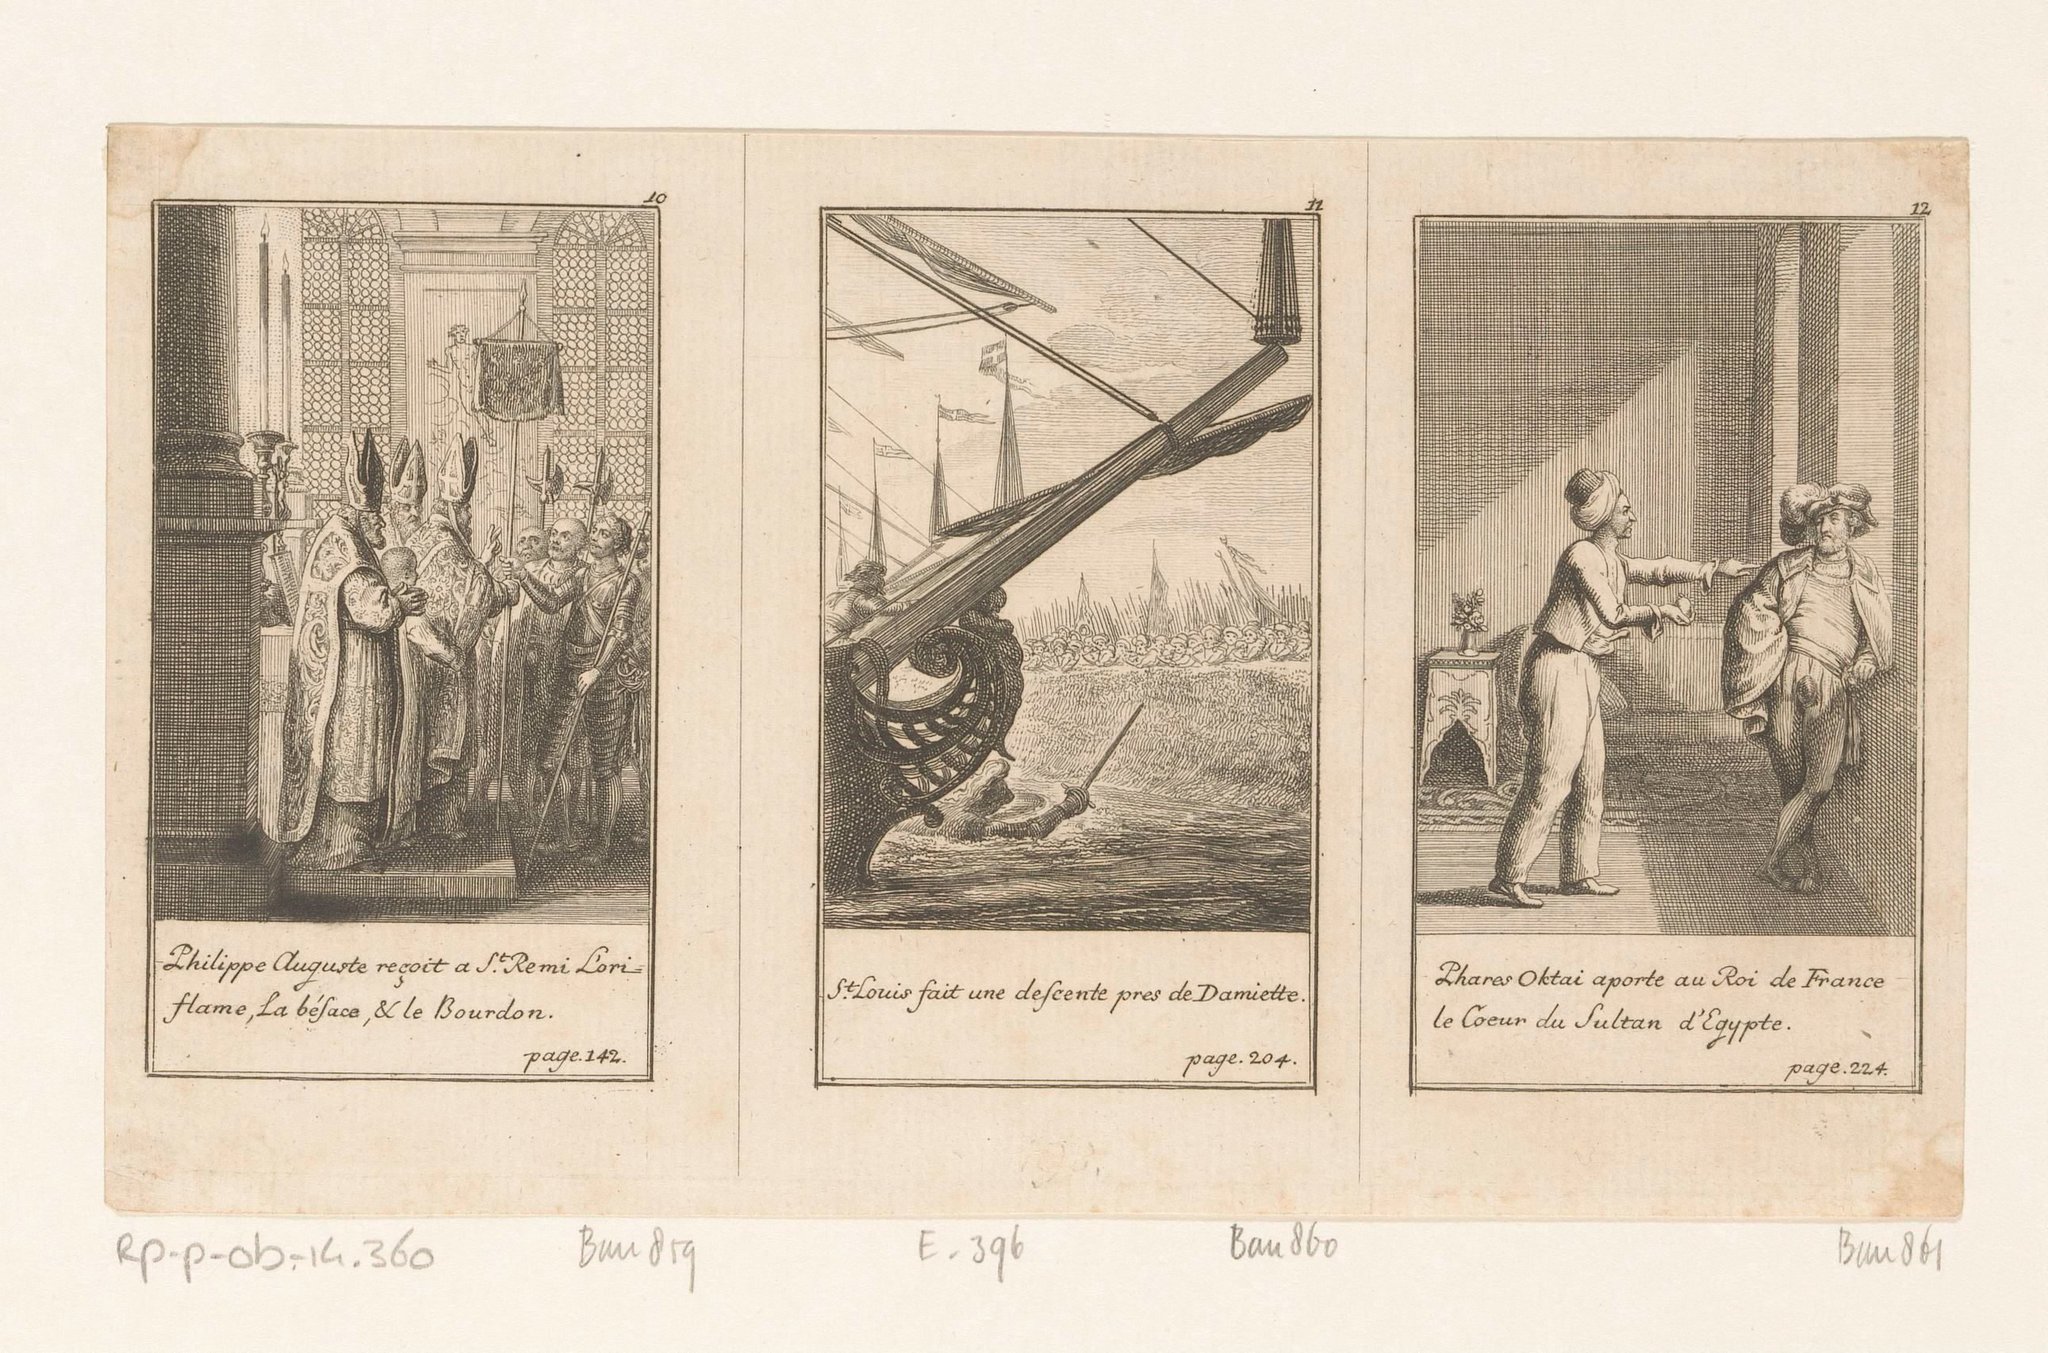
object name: book illustration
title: Drie voorstellingen uit Histoire des Croïsades van Maier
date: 1781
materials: paper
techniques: etching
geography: gotha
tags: paris, hacking and thrusting weapons: sword, ships (in general), head-gear: turban, militant proselytizing: religious war, crusade, etc., louis ix, king of france; possible attributes: crown of thorns, fleur-de-lis on his coat, three nails, sceptre with fleur-de-lis, model of church, hand of justice, heart, banner, standard (as symbol of the state, etc.), altar, charge ~ battle, index finger forwards, pointing, indicating, blessing by the priest ~ holy mass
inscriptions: collector's mark: Lugt 2228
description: Rechtsboven genummerd van tien tot en met twaalf, met onderschrift in het Frans. Afgebeeld zijn: Filips II wordt gezegend voor hij op kruistocht gaat (10), Lodewijk IX springt van zijn schip en zet de aanval in (11) en Lodewijk IX krijgt het hart van de Egyptische Sultan aangeboden (12).